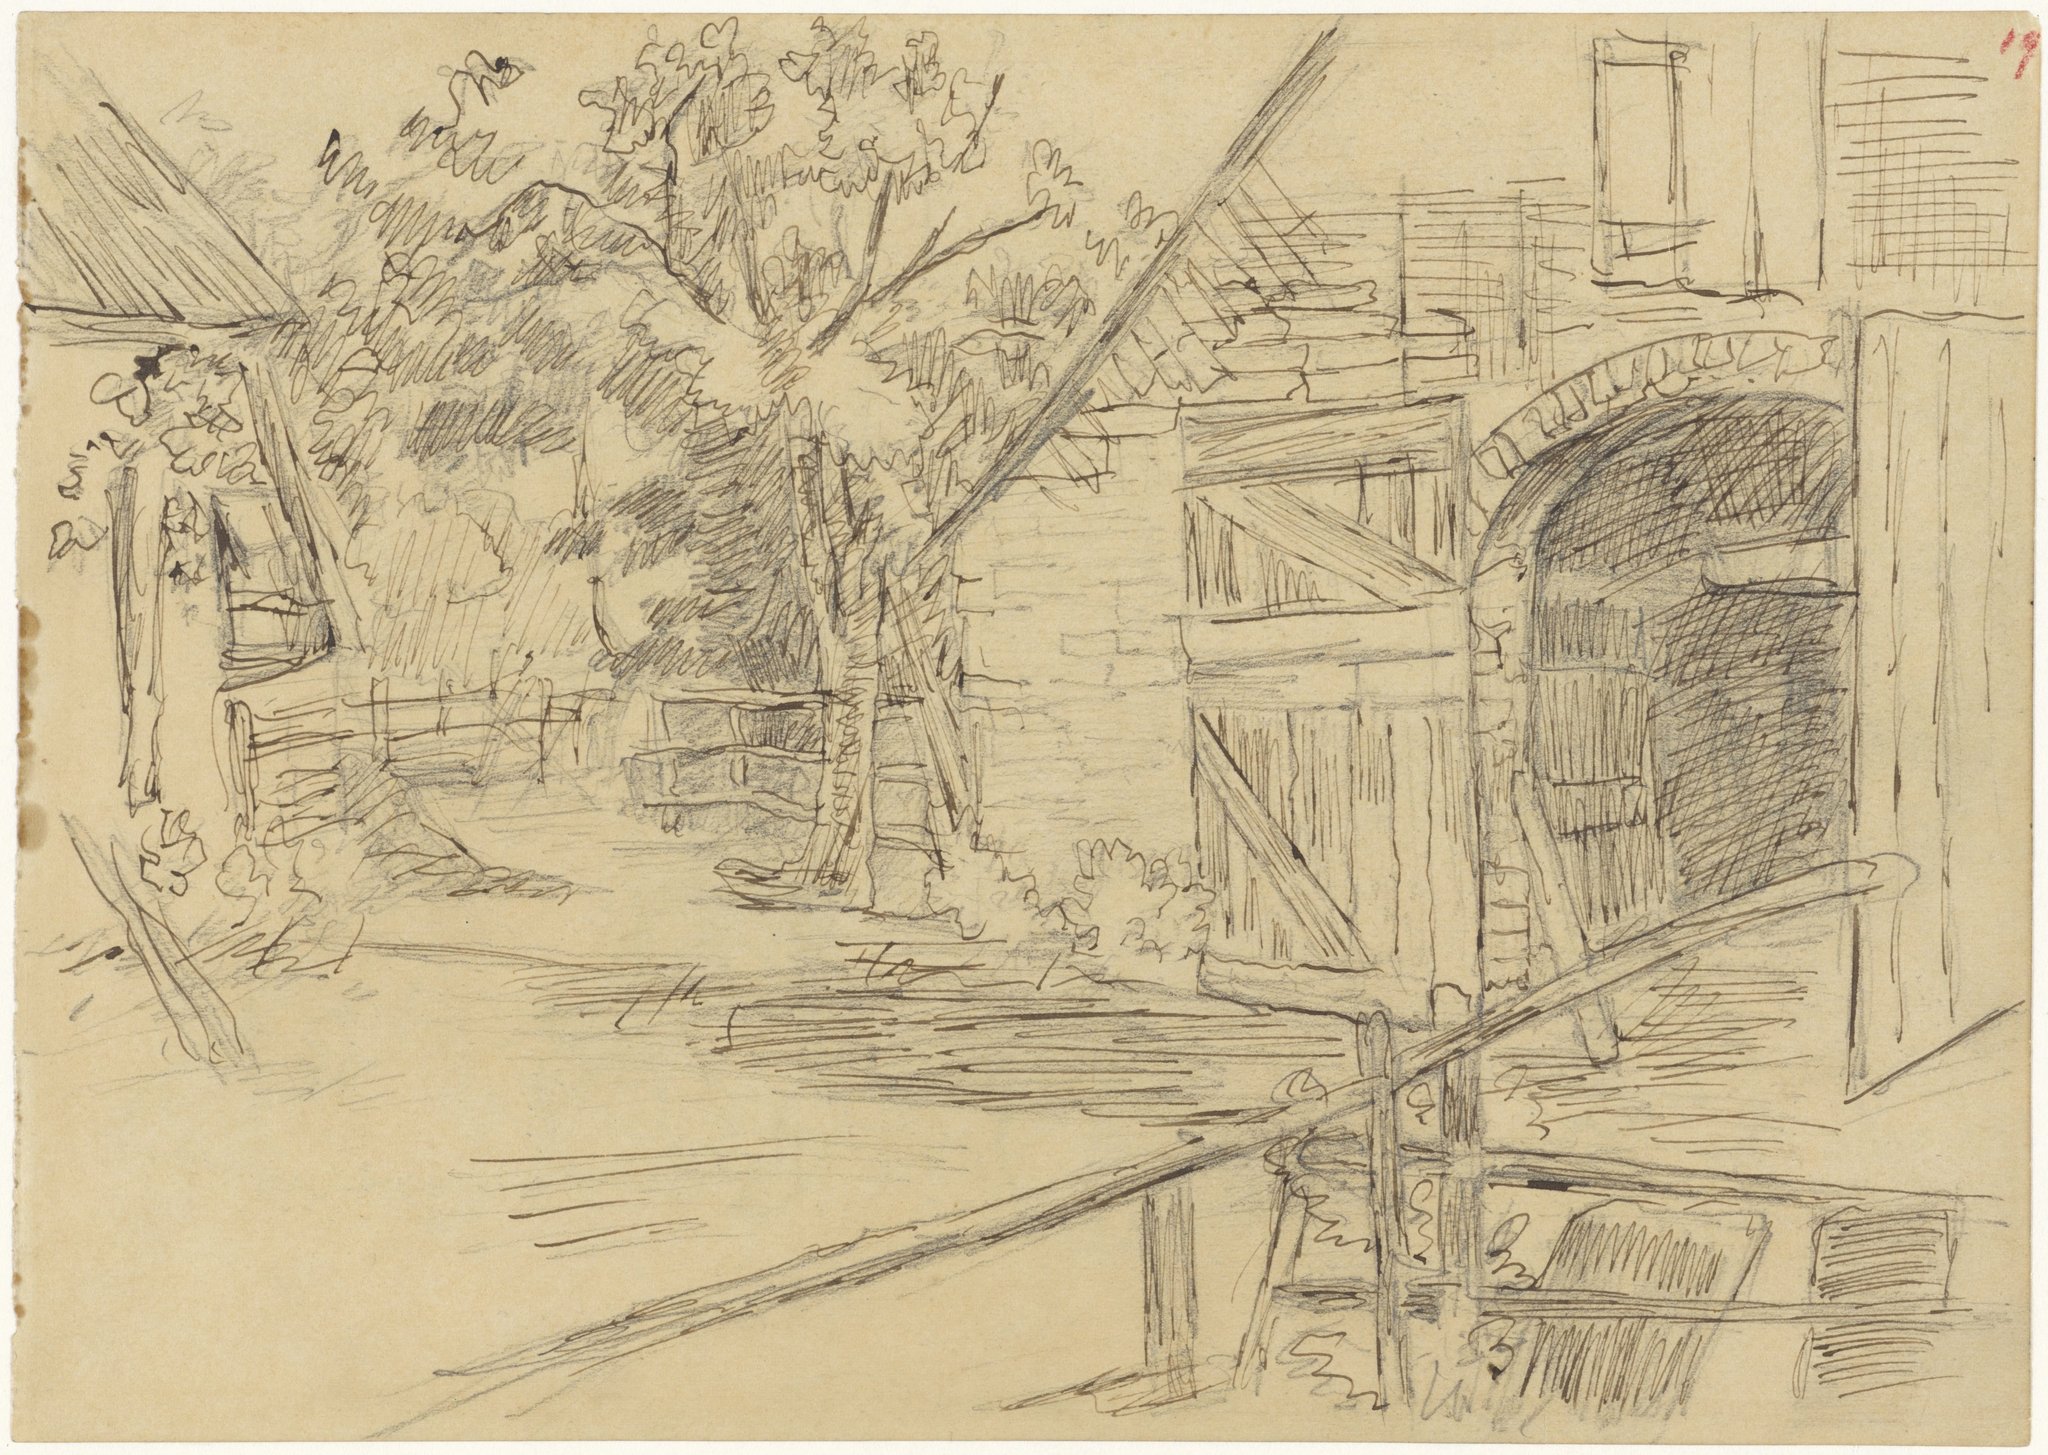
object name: drawing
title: Erf met een schuur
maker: jozef israëls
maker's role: draughtsman, painter, print maker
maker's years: 1824-1911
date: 1834-1911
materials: ink, paper, pencil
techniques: pen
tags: farm (building)